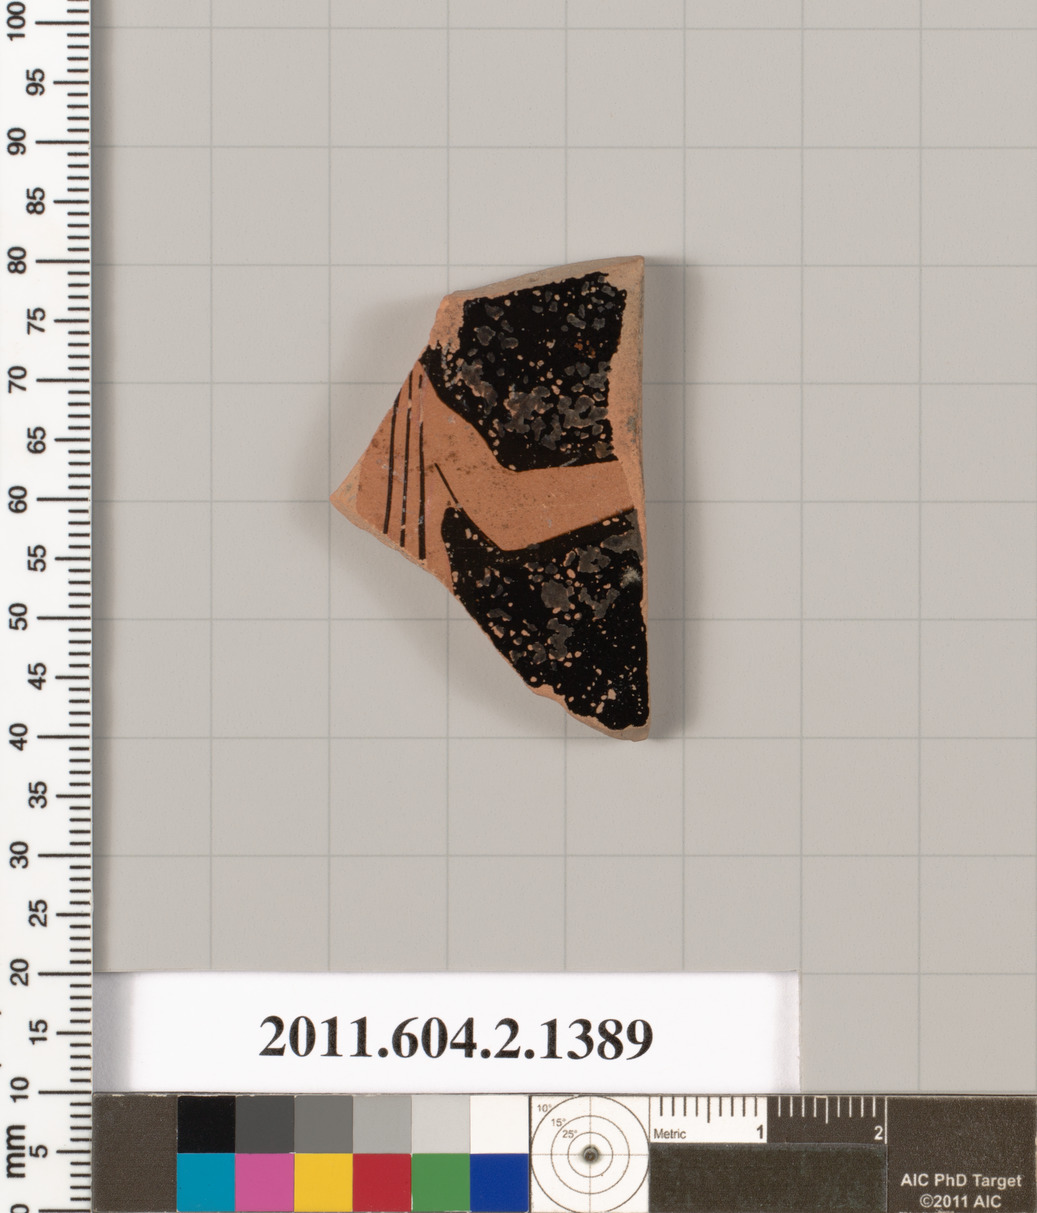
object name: skyphos fragment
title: Terracotta fragment of a skyphos (deep drinking cup)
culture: greek, attic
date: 450-430 BCE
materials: terracotta